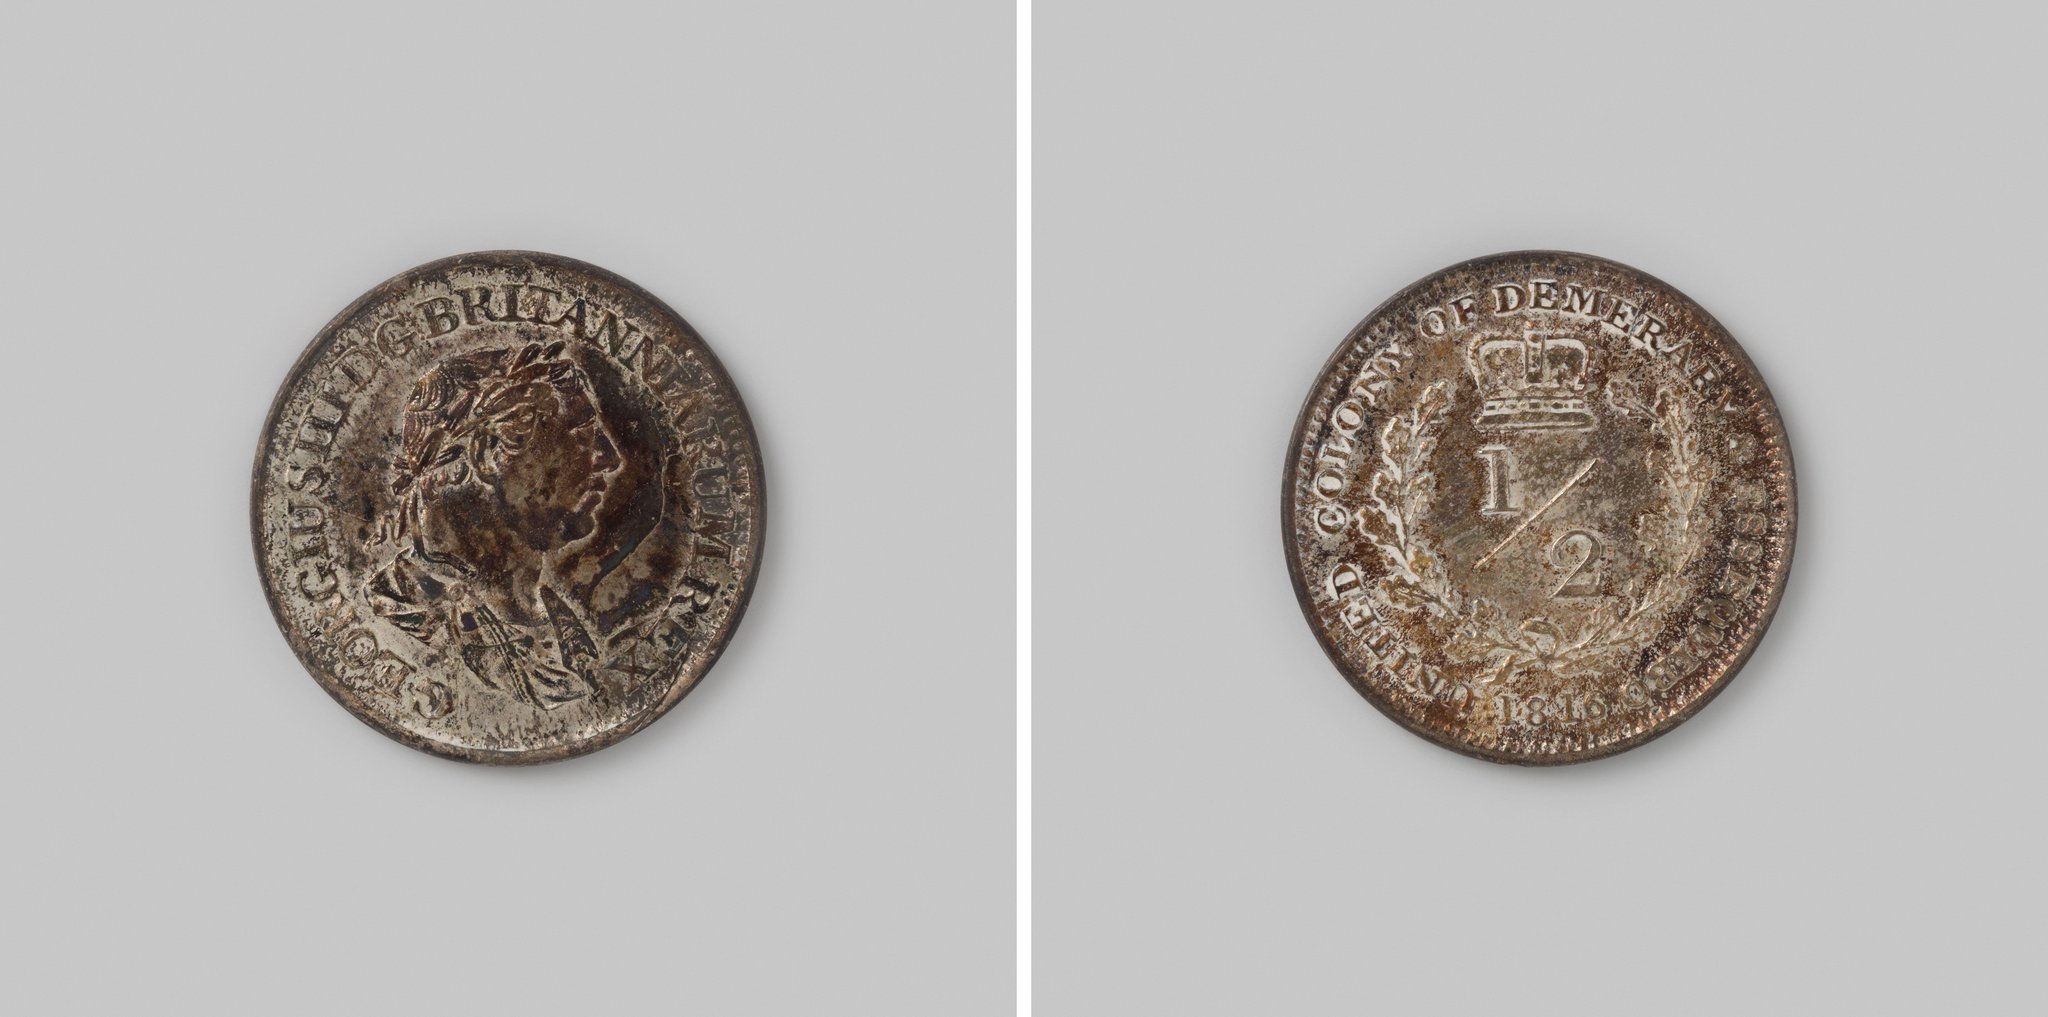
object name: coin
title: ½ guilder uit Essequibo & Demarary van koning George III, 1816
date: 1816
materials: silver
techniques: striking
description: Zilveren munt. Voorzijde: gelauwerd borstbeeld van de koning naar rechts. Keerzijde: tussen twee samengebonden takken waarde-aanduiding: ½ , waarboven kroon. Jaartal onderaan in omschrift. Gladde rand.